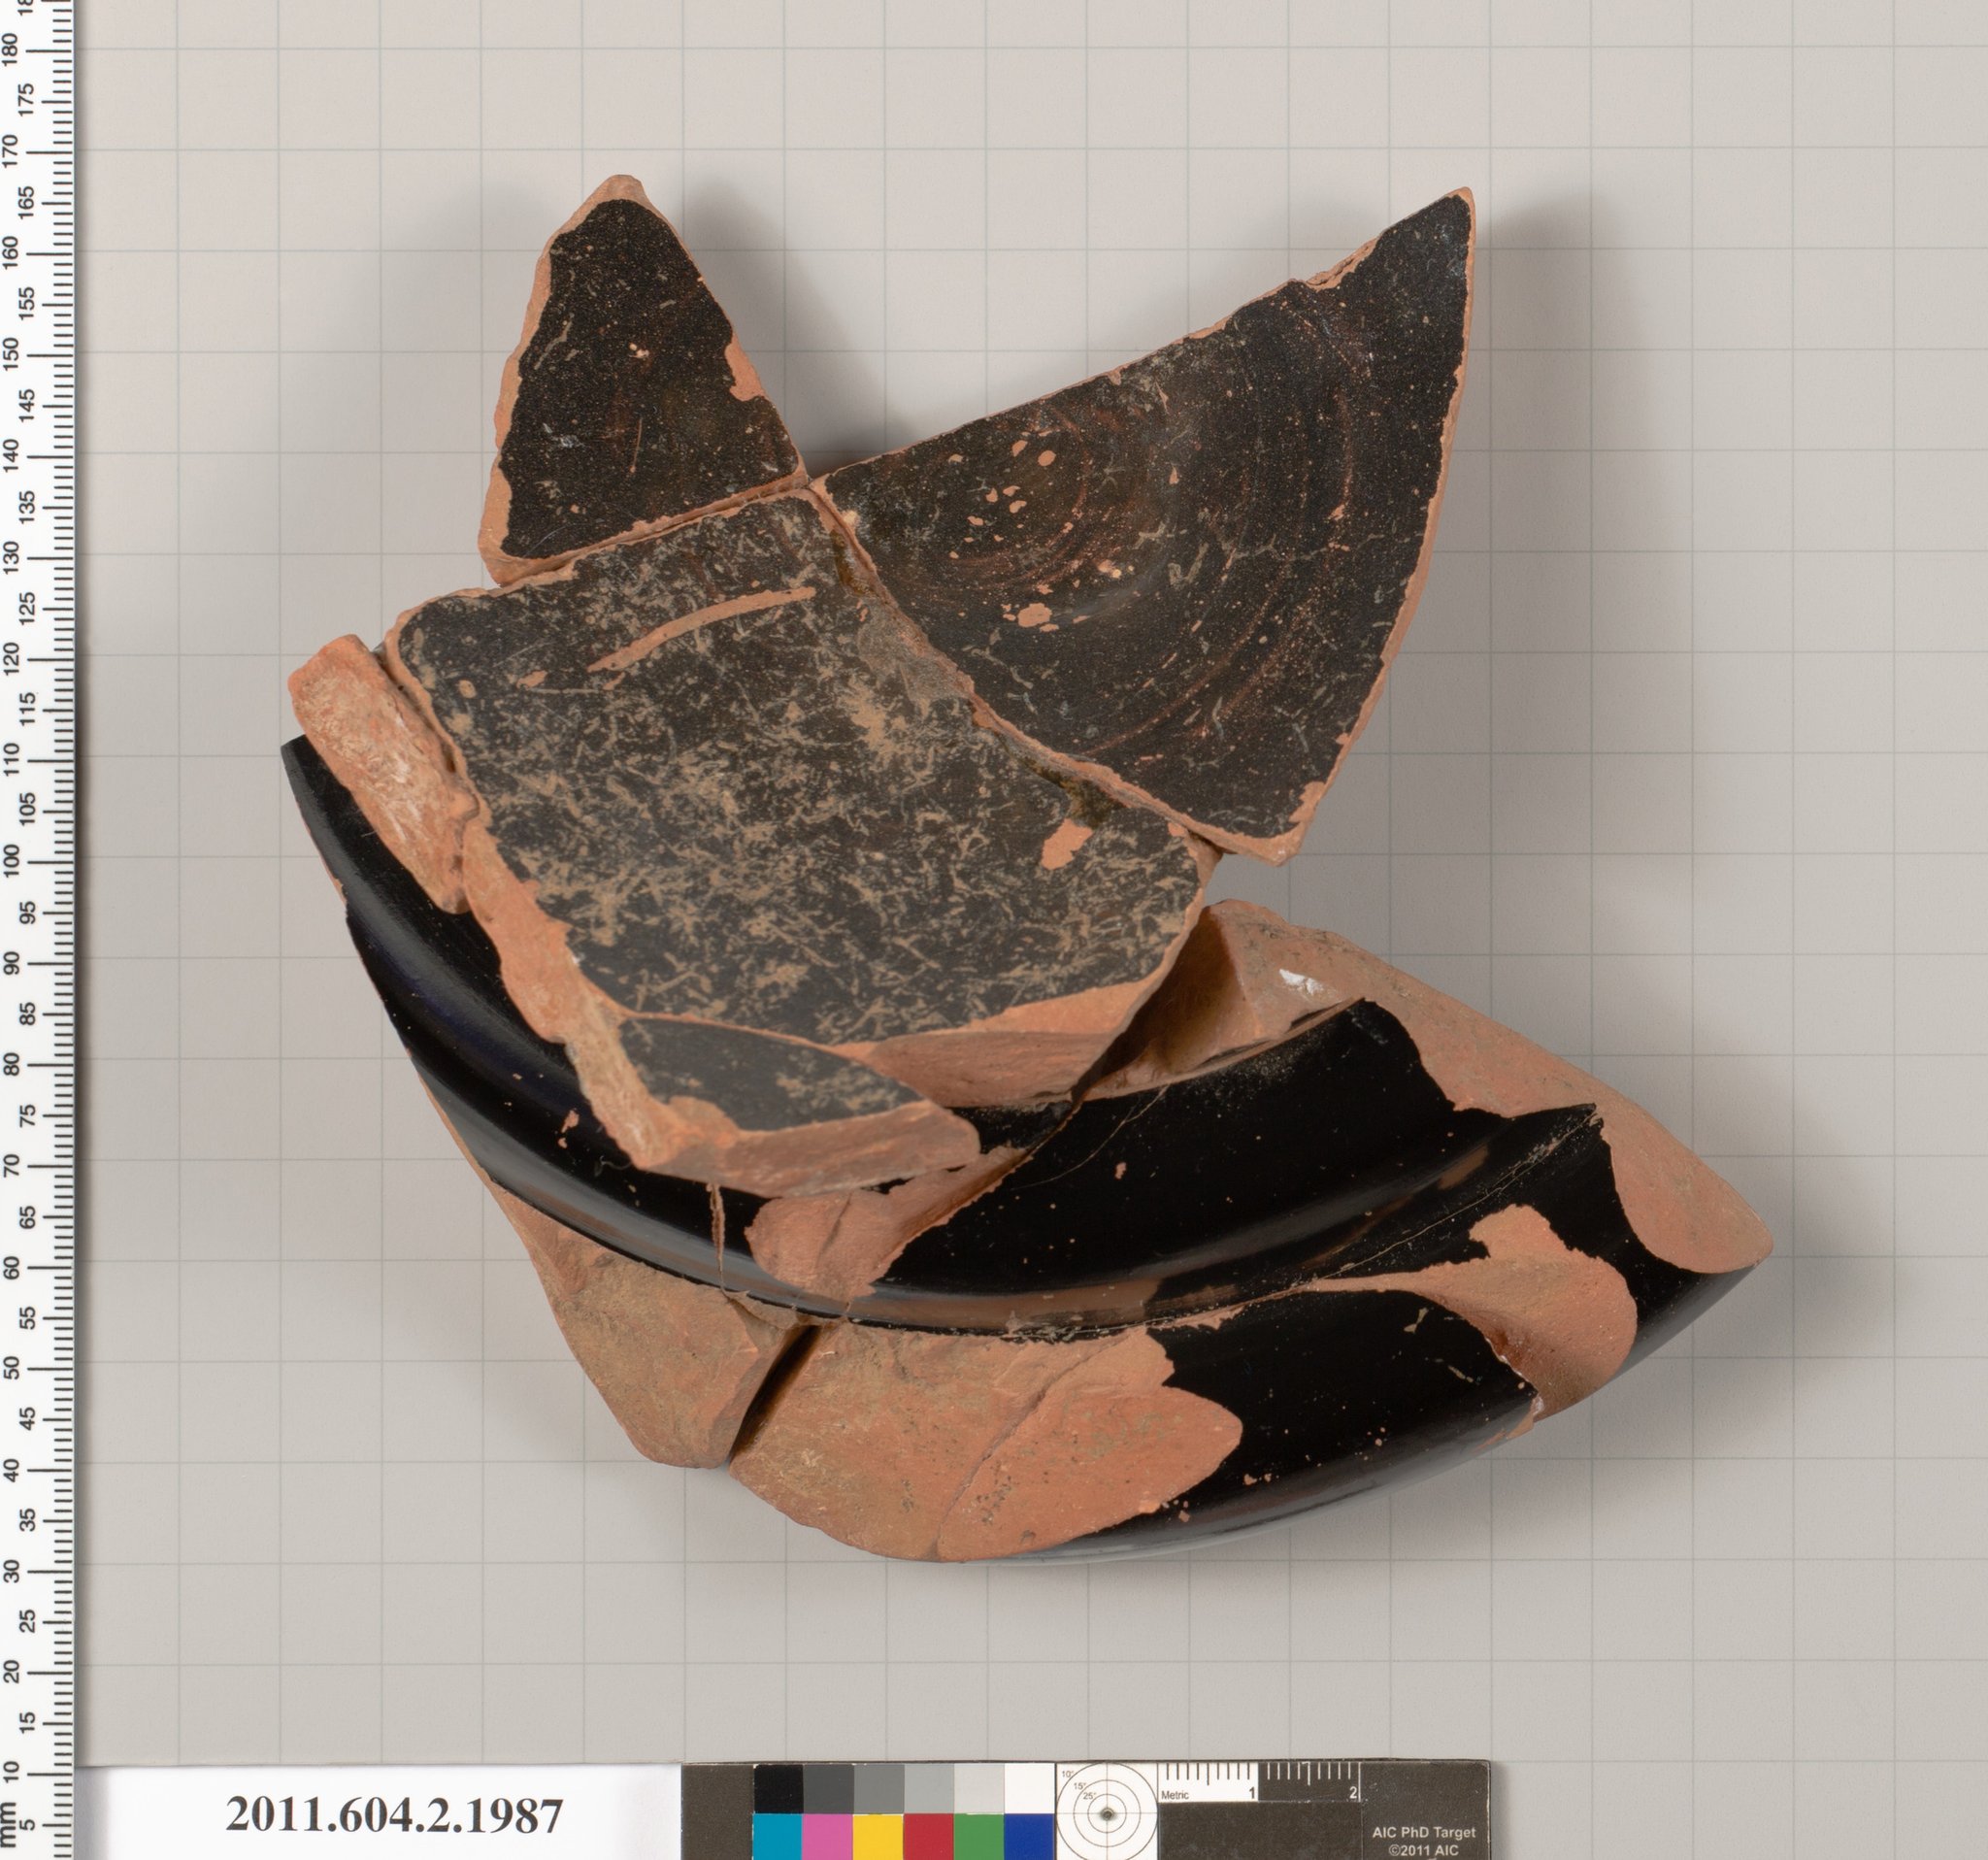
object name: krater fragment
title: Terracotta fragment of a krater (bowl for mixing wine and water)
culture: greek, attic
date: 475-451 BCE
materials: terracotta